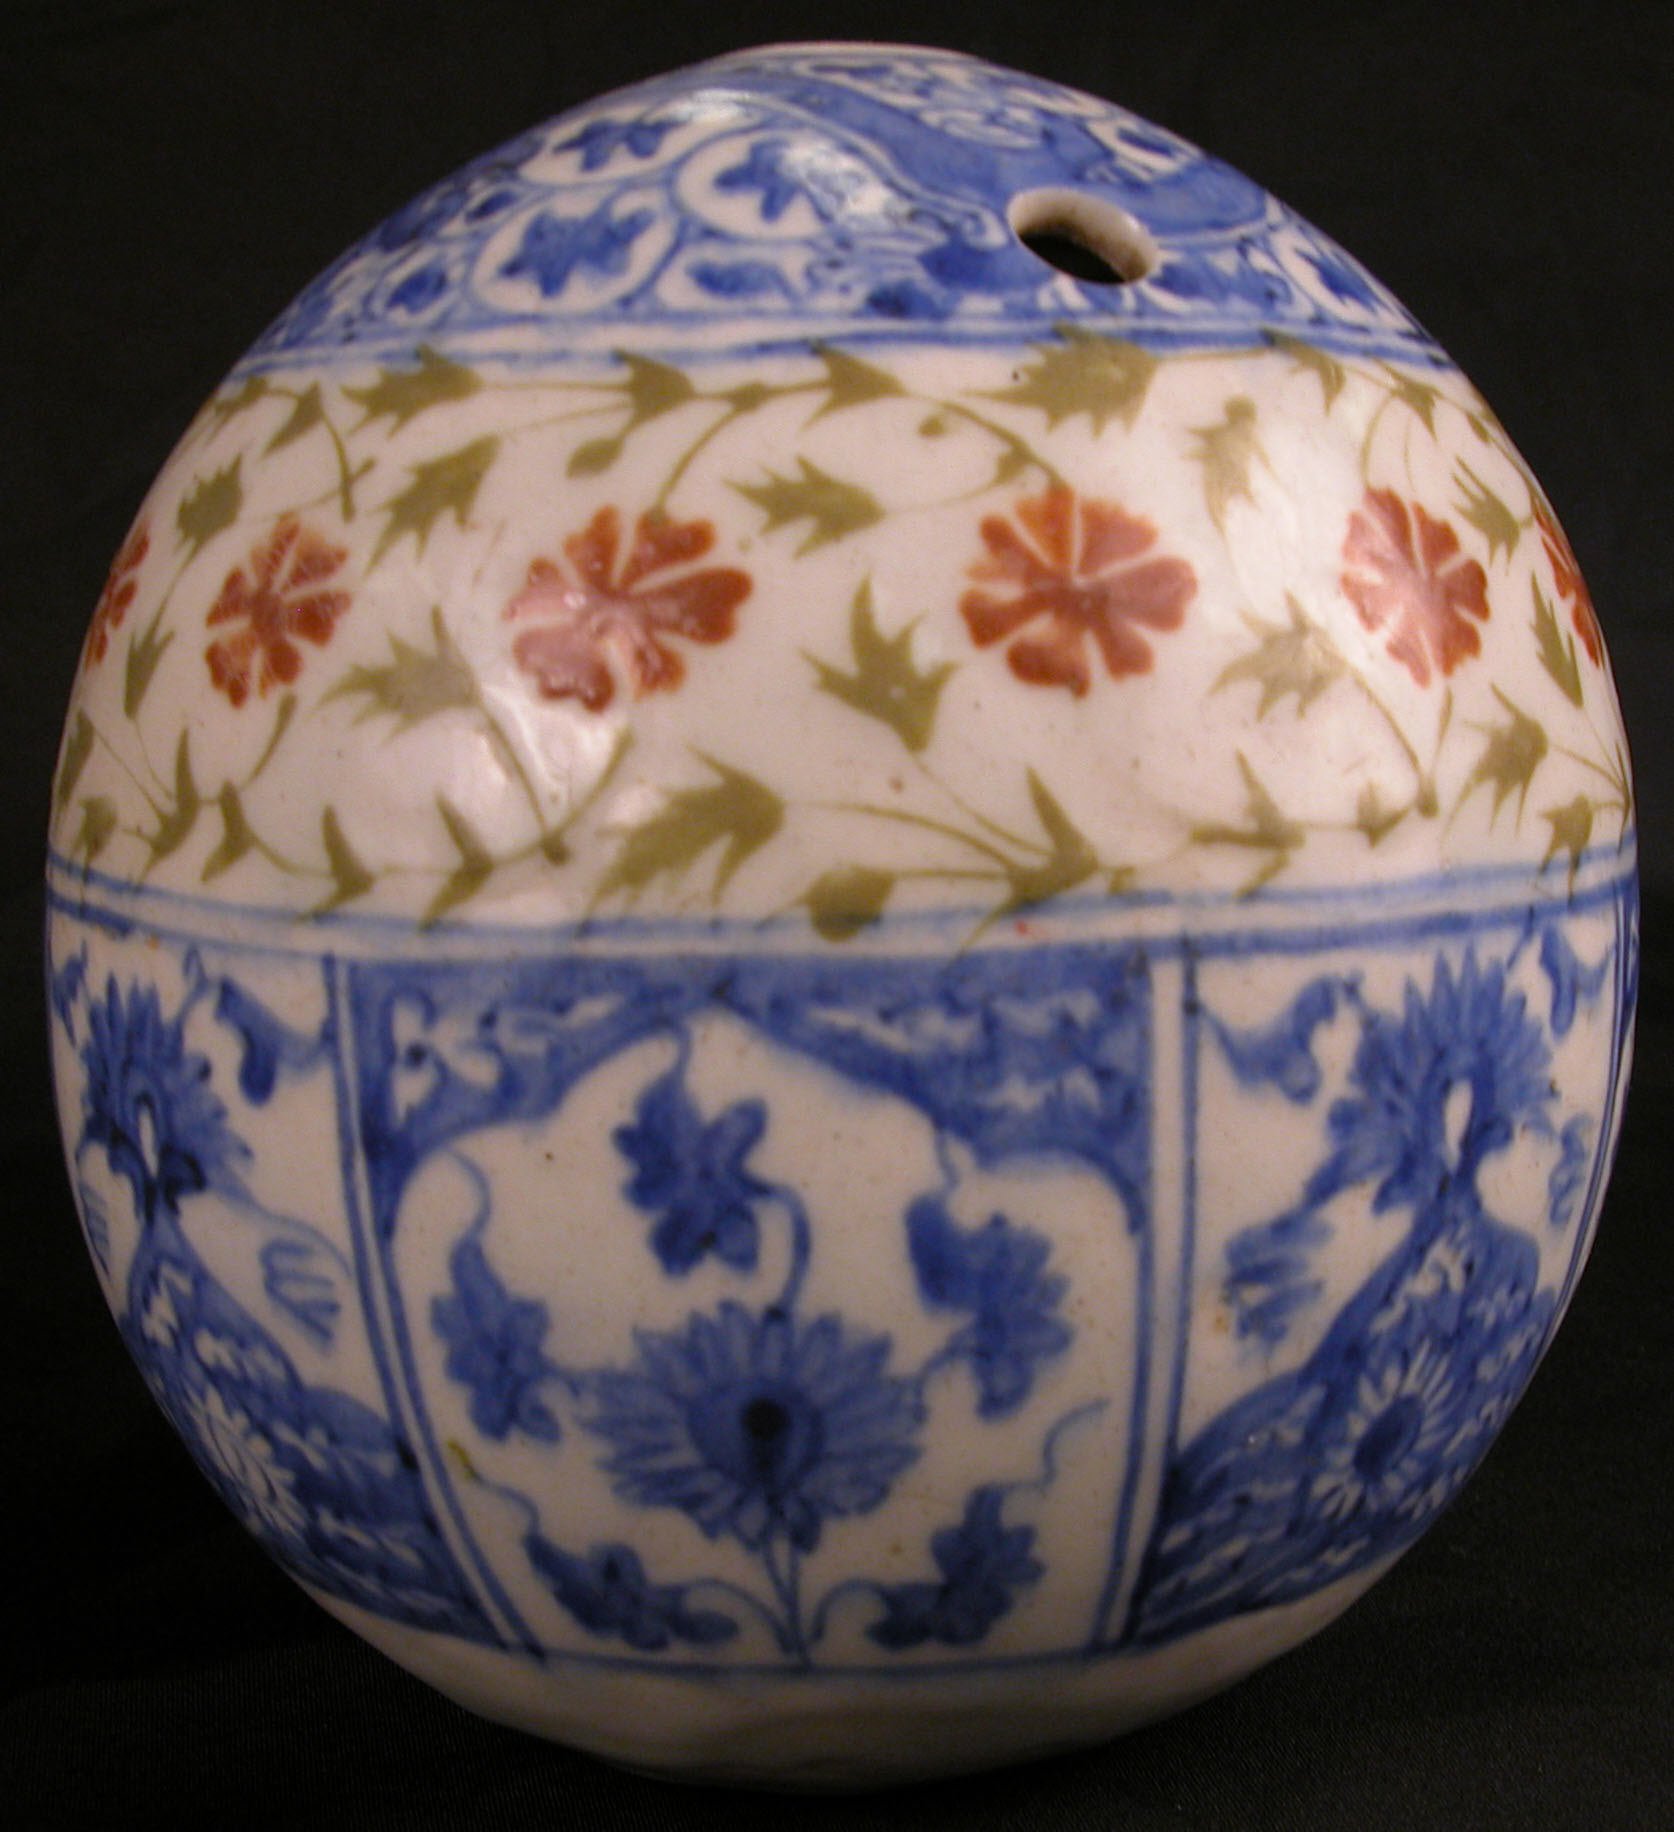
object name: water pipe base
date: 1651-1700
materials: stonepaste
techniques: painting, underglaze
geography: iran